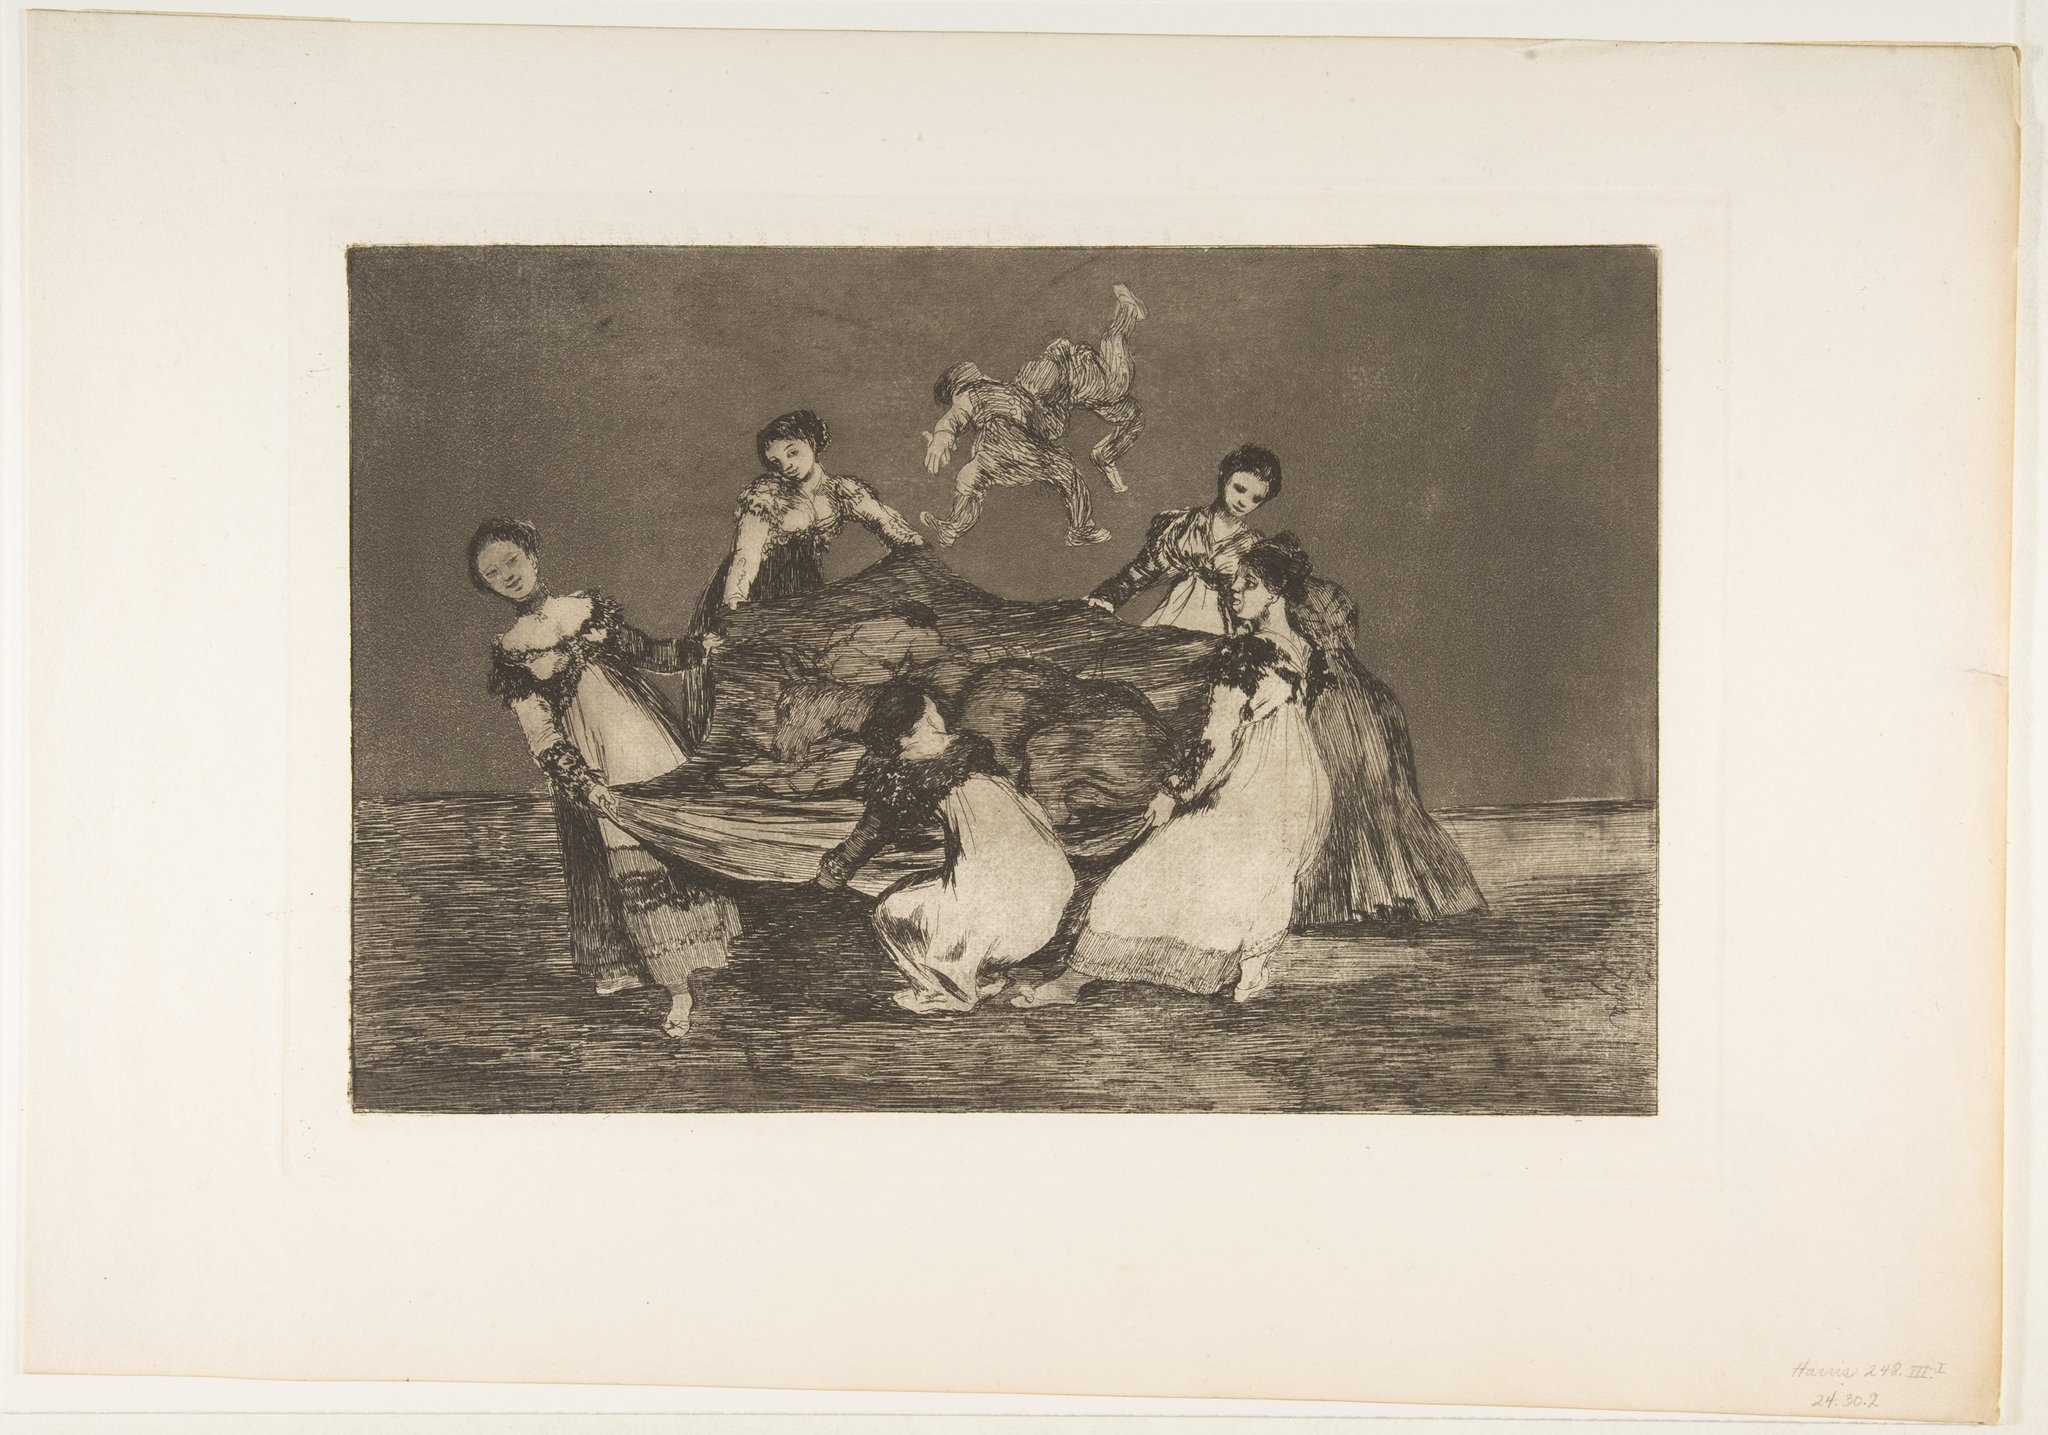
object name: print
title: Feminine Folly, from "The Disparates" (Follies / Irrationalities)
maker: goya (francisco de goya y lucientes)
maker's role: artist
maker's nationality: spanish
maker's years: 1746-1828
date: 1815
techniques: aquatint, drypoint, etching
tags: women